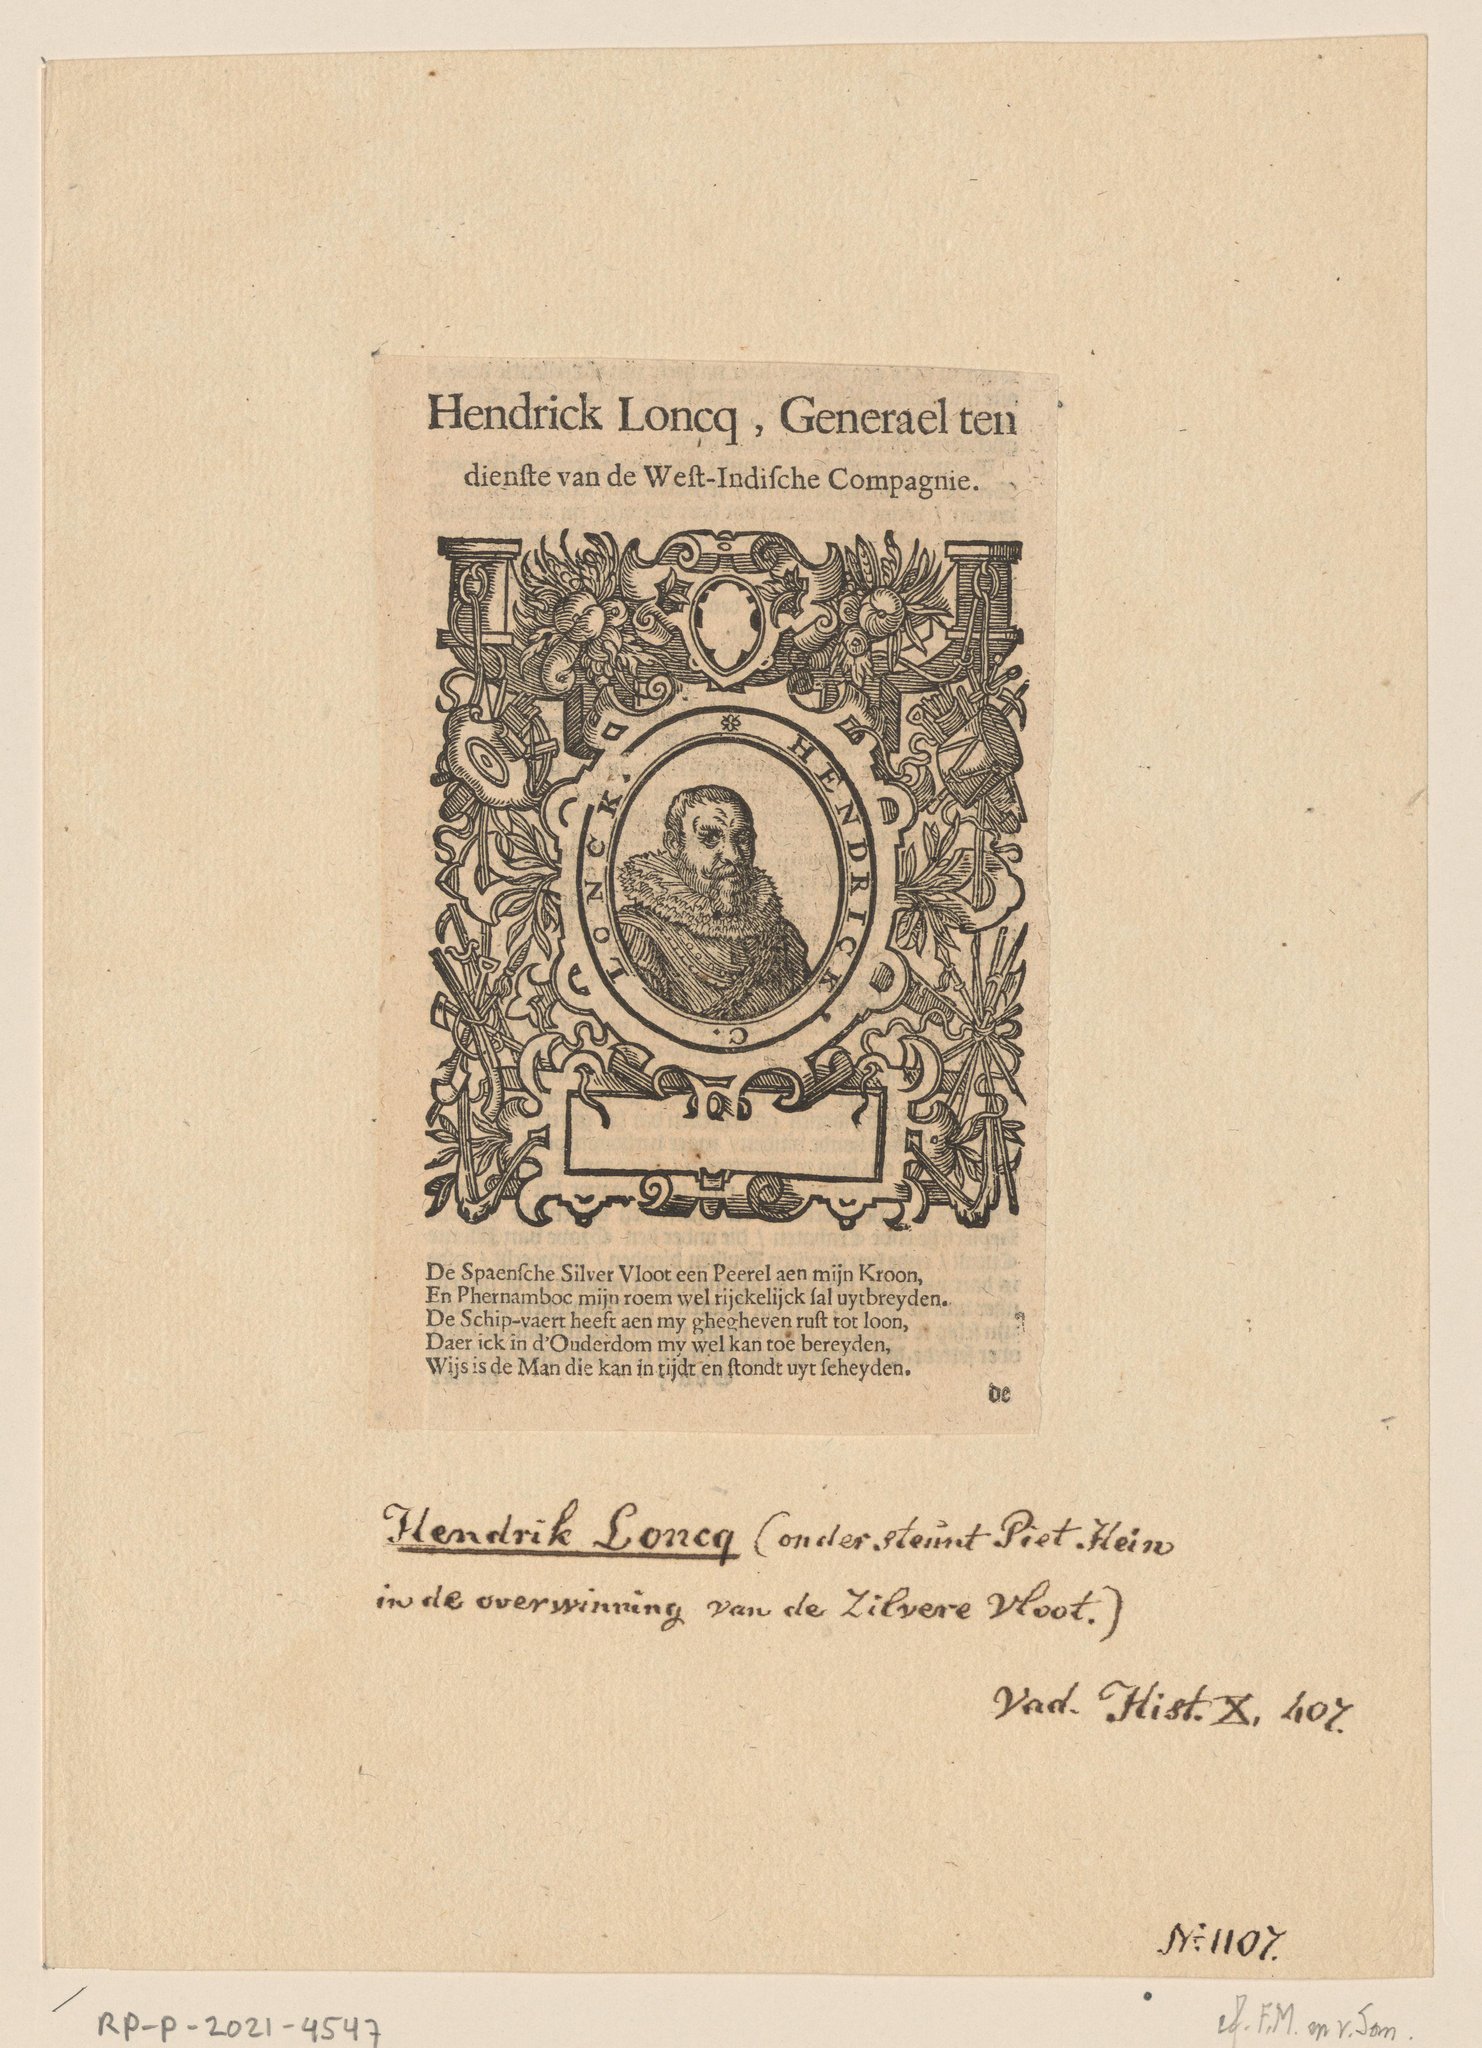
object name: book illustration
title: Portret van Hendrik Loncq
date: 1646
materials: paper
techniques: letterpress printing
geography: amsterdam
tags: ornament ~ medallion, historical persons, commander-in-chief, admiral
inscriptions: inscription: ‘Hendrik Loncq (ondersteunt Piet Hein/ in de overwinning van de Zilvere Vloot.)/ Vad. Hist. X, 407./ No. 1107.’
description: Prent uit: Scriverius, Petrus. Beschrivinge van Out Batavien (...). Amsterdam: Broer Jansz., 1646, p. 218. Prent met andere omlijstingen gebruikt in de editie van 1636.